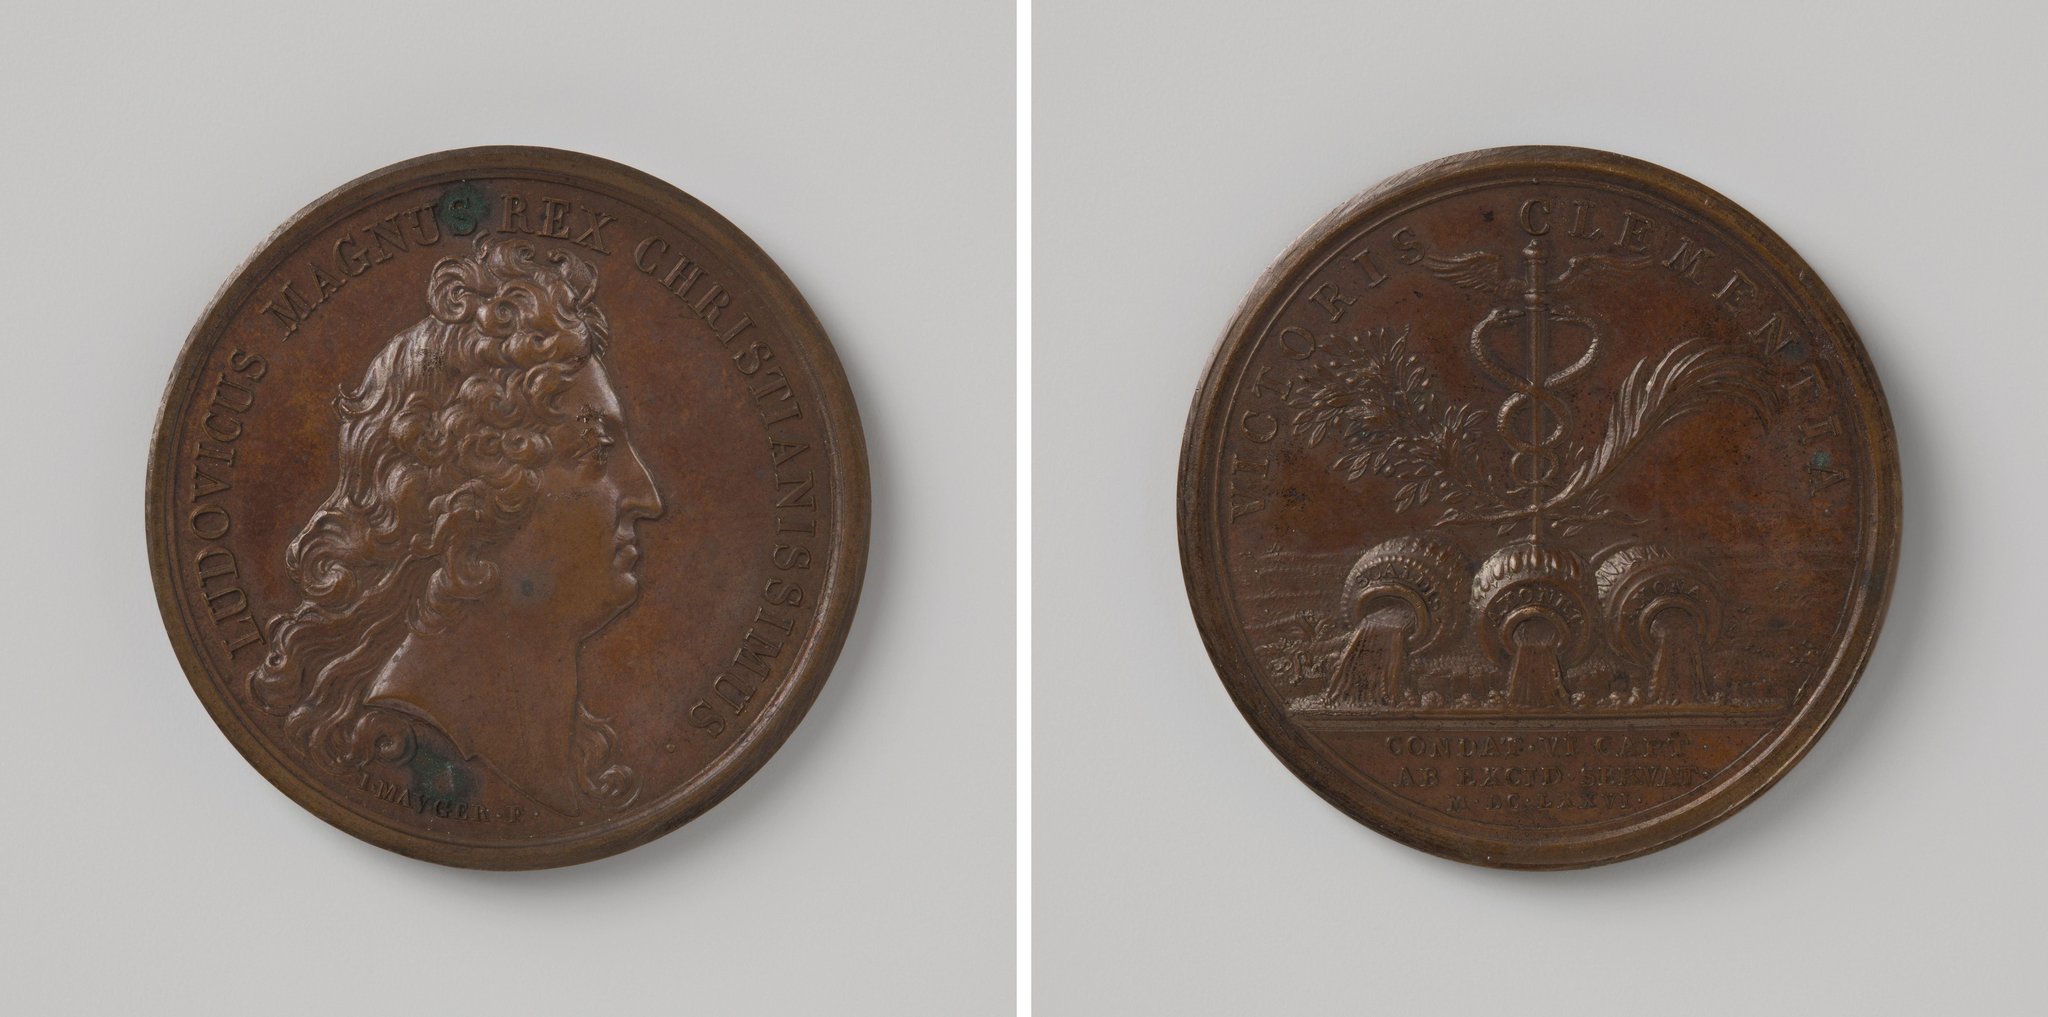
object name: history medal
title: Inname van Conde door Lodewijk XIV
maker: jean mauger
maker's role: medailleur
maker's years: 1648-1722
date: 1699-1703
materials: bronze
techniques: striking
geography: paris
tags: lodewijk xiv (koning van frankrijk)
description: Bronzen penning. Voorzijde: borststuk man binnen omschrift. Keerzijde: drie waterkruiken voorstellende de rivieren Schelde, Aisne en Haisne met daartussen Mercuriusstaf met palm- en lauriertak binnen omschrift.